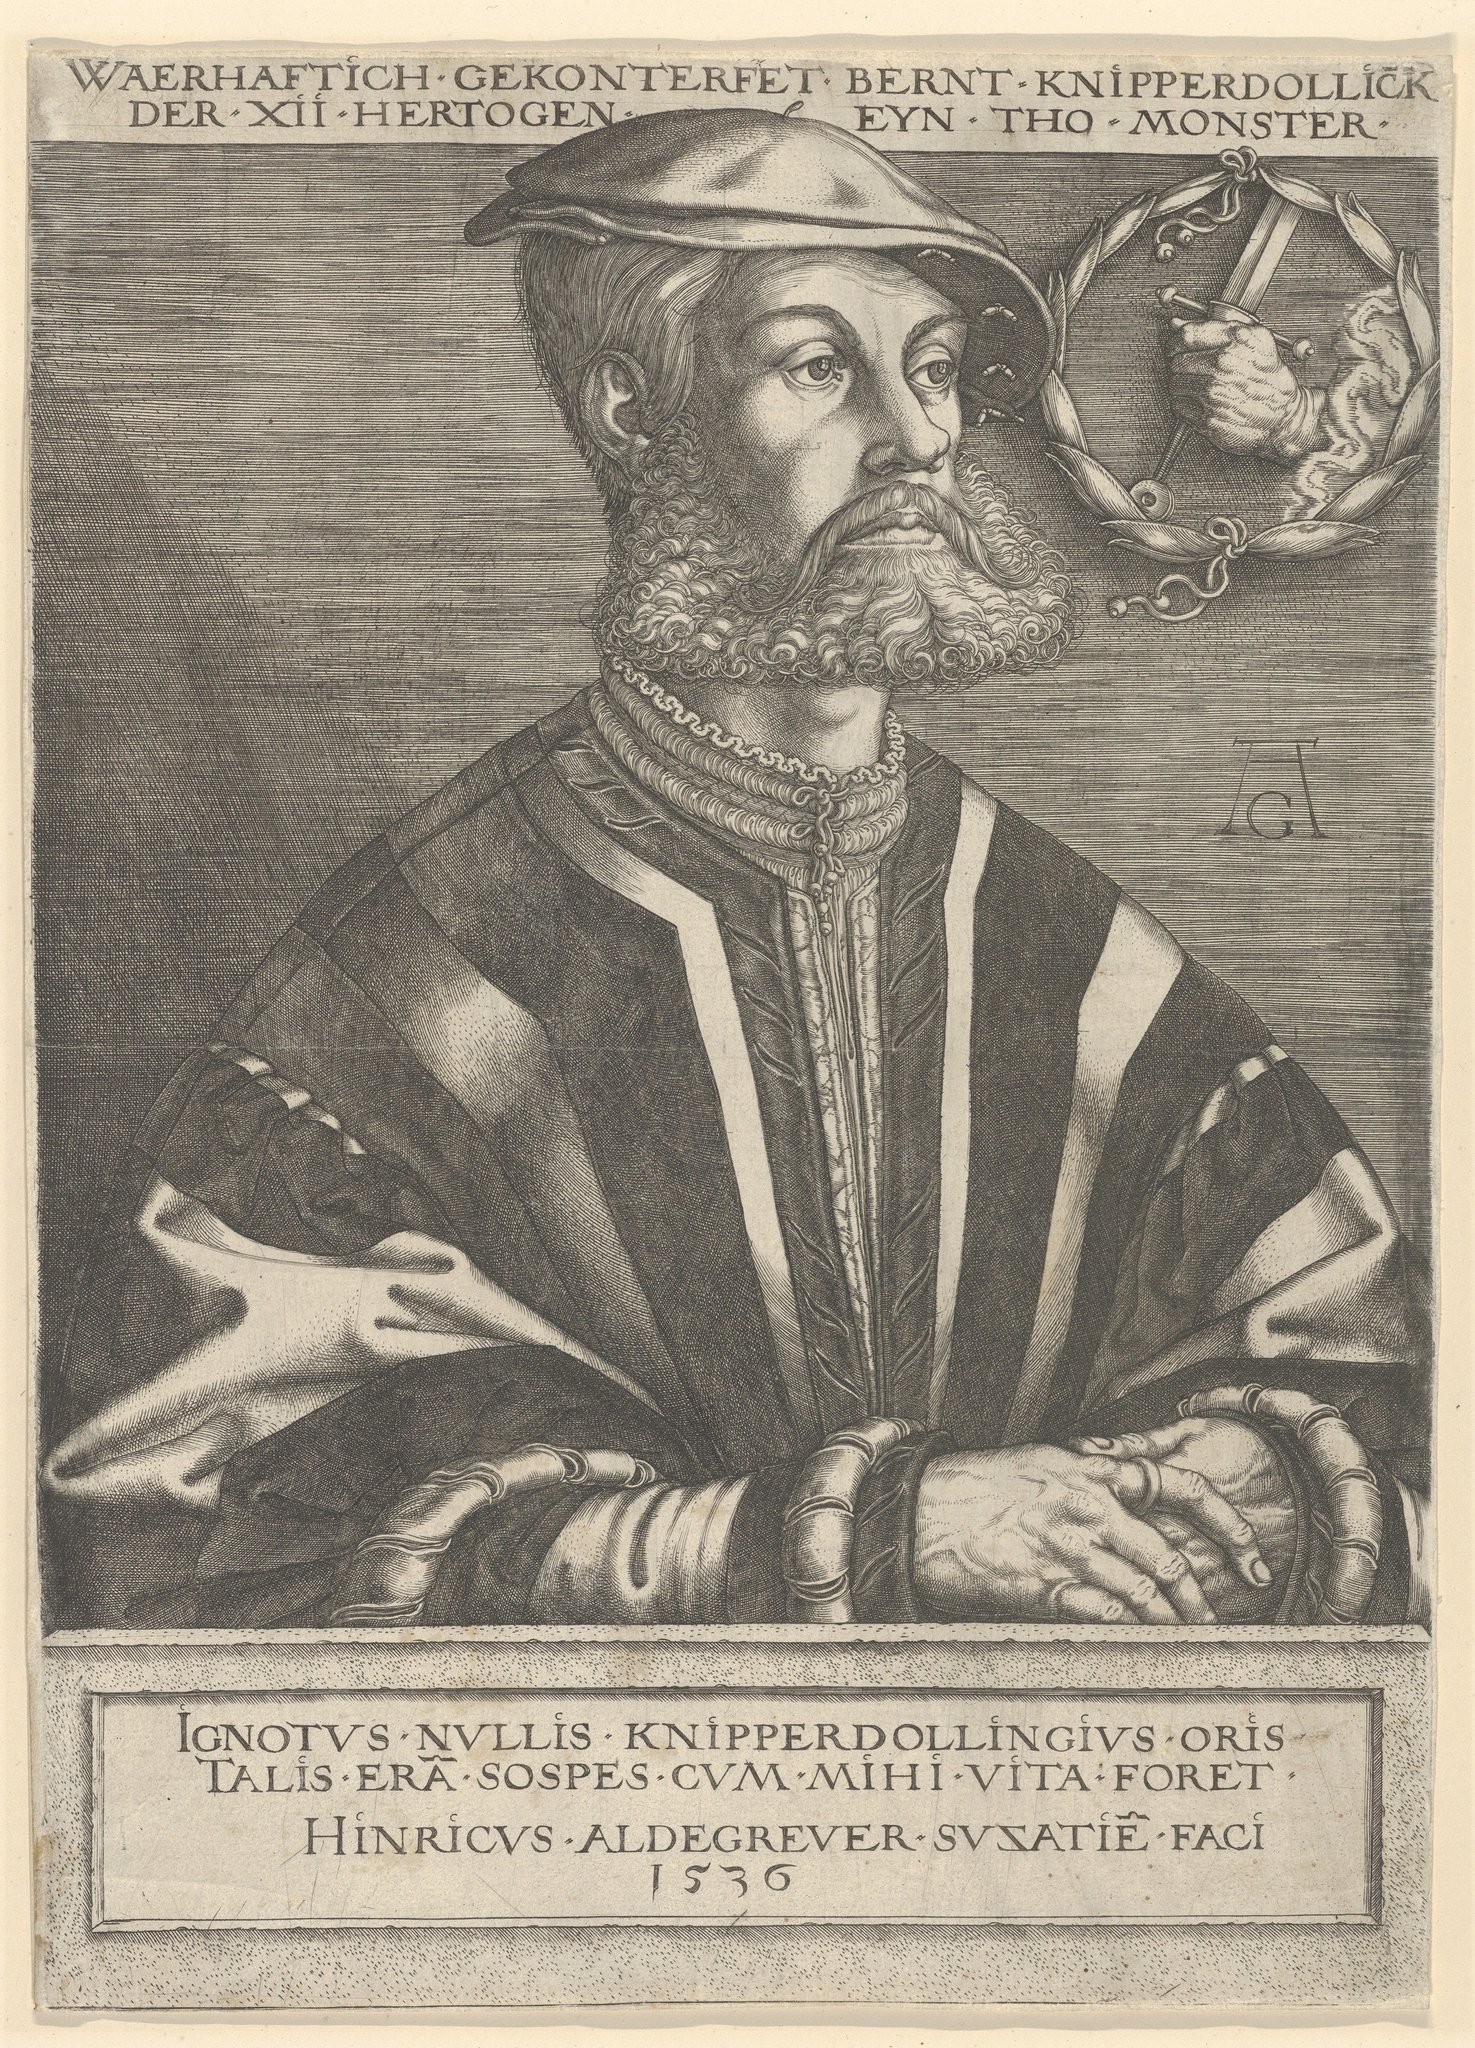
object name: print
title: Bernt Knipperdolling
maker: heinrich aldegrever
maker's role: artist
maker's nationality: german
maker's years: 1502-1561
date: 1536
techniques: engraving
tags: men,portraits